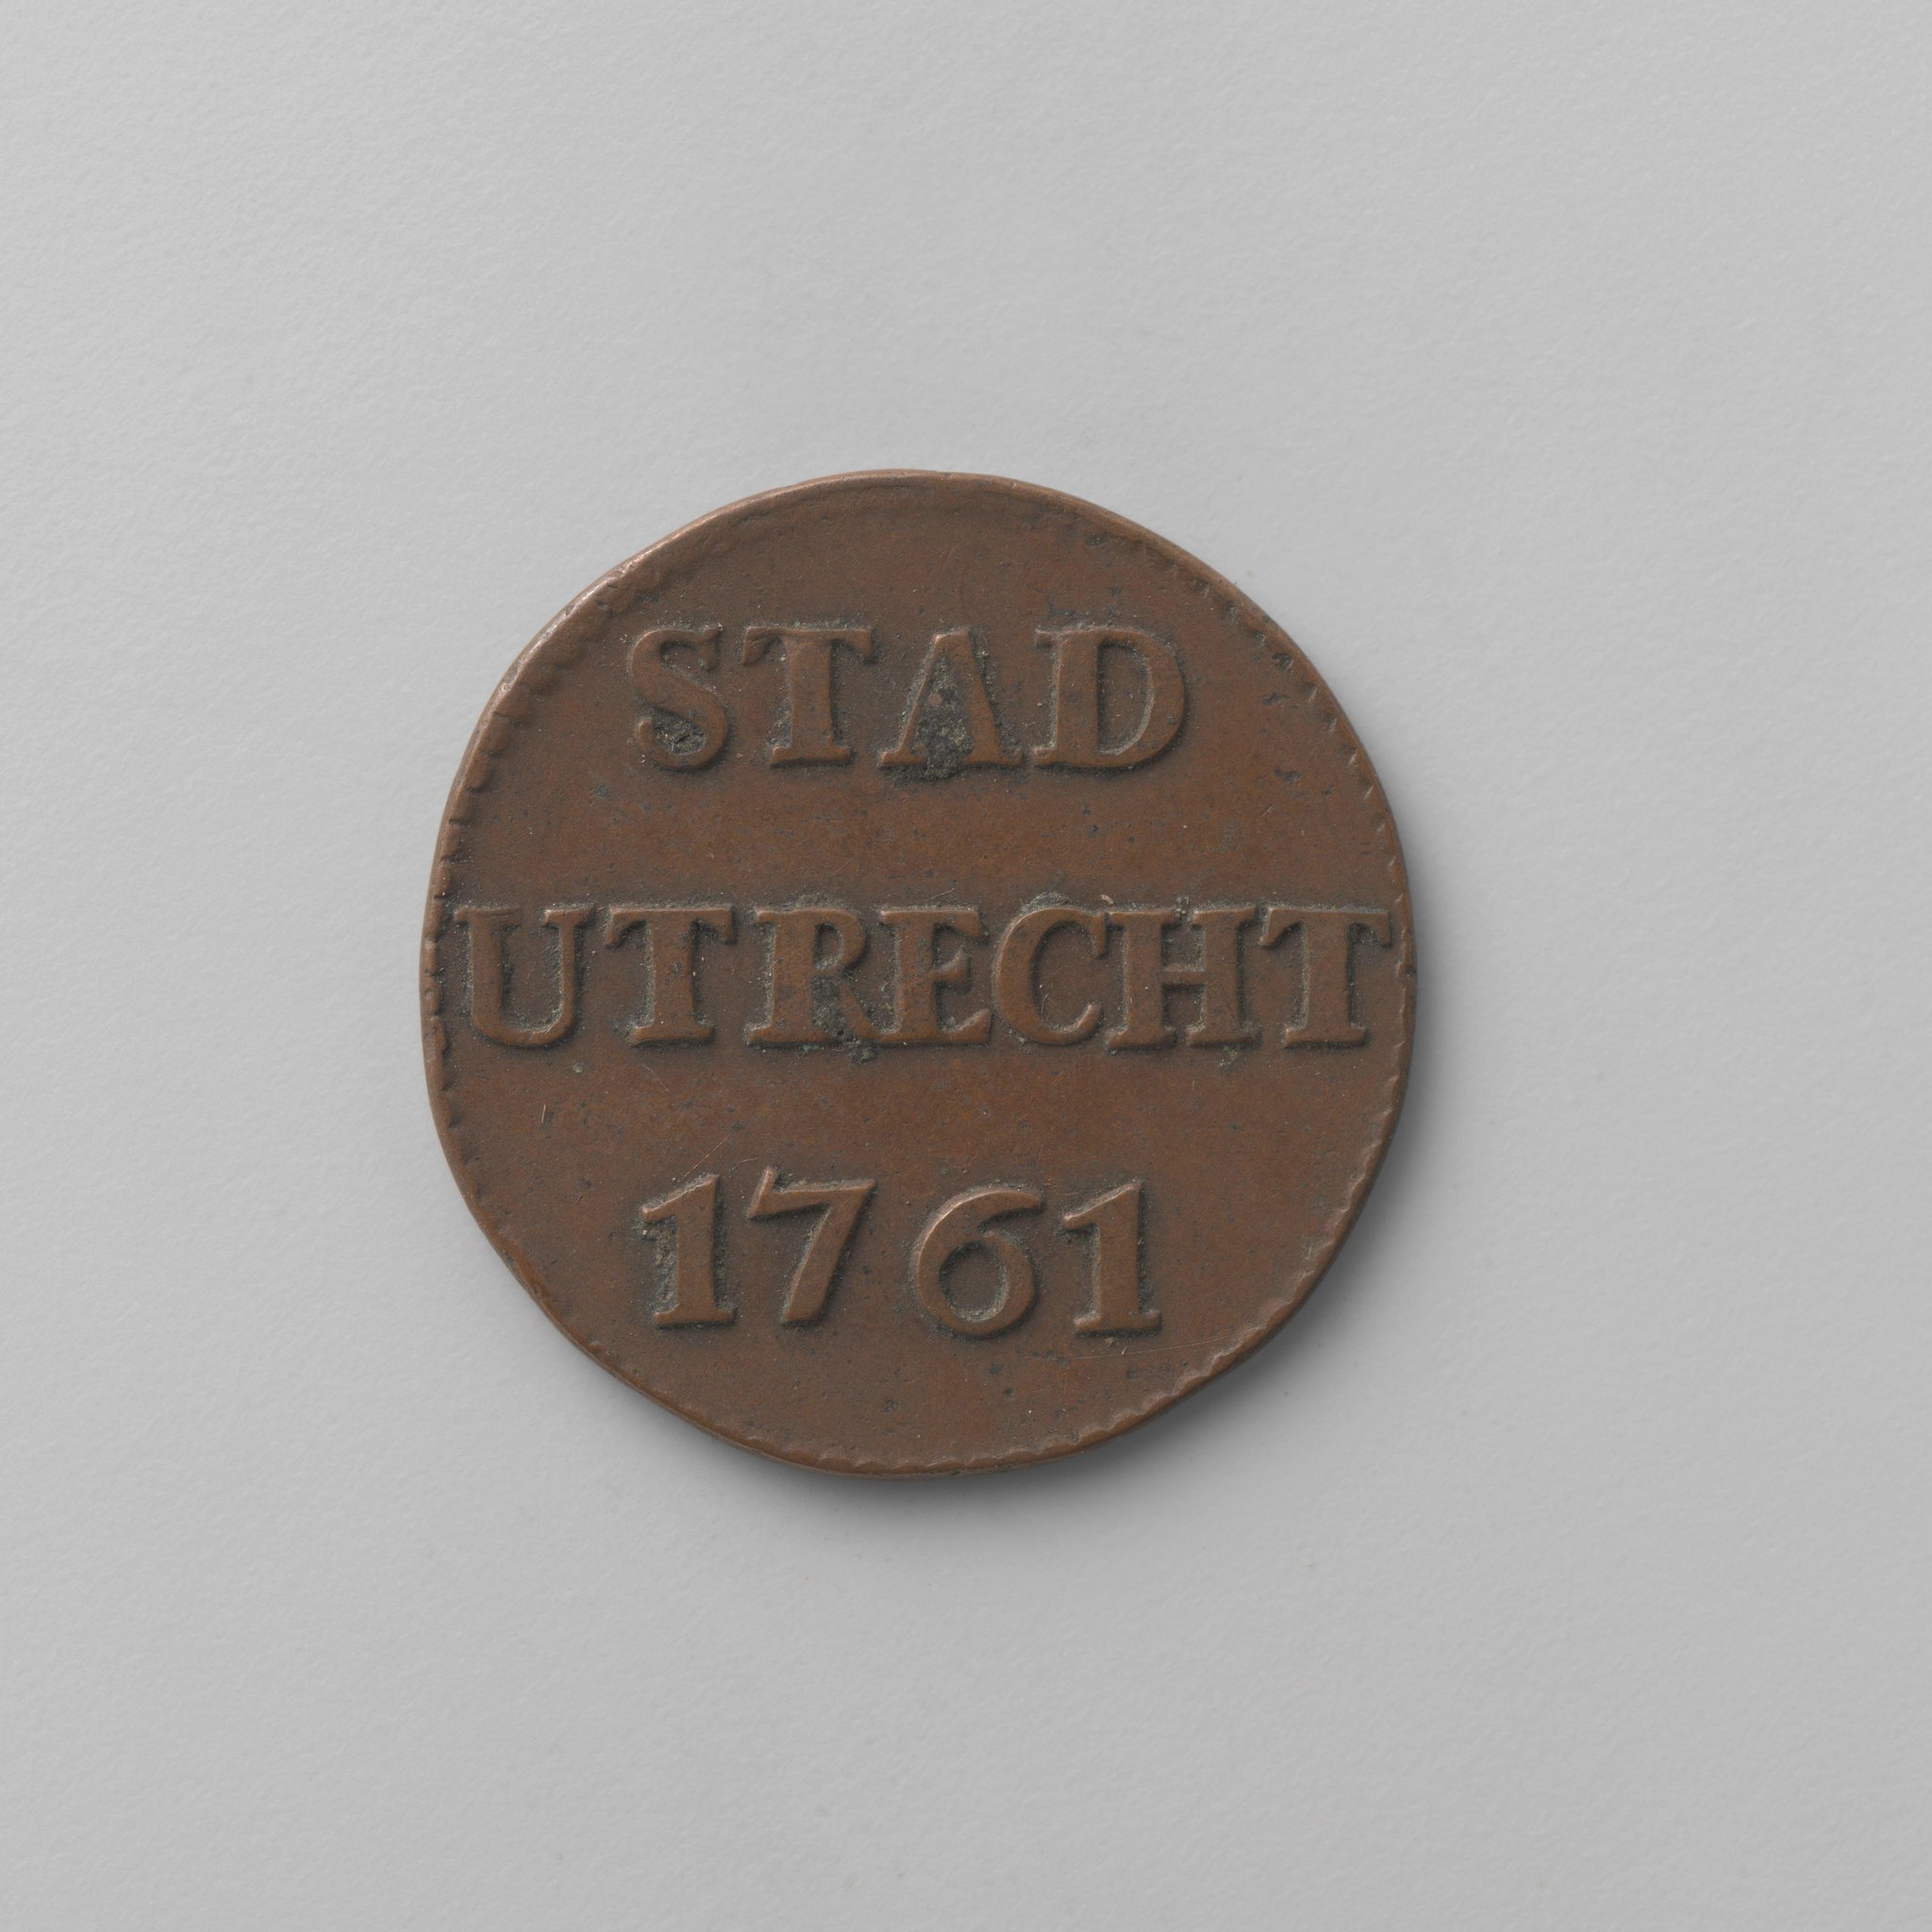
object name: coin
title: Duit van de stad Utrecht, 1761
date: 1761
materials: copper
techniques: striking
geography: utrecht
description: Koperen munt. Voorzijde: gekroond stedelijk wapenschild, gehouden door twee leeuwen met in afsnede dikke lijn, waaronder een versierde accolade met een grote schelp. Keerzijde: opschrift in twee regels, waaronder jaartal. Jaartal met Arabische 1.